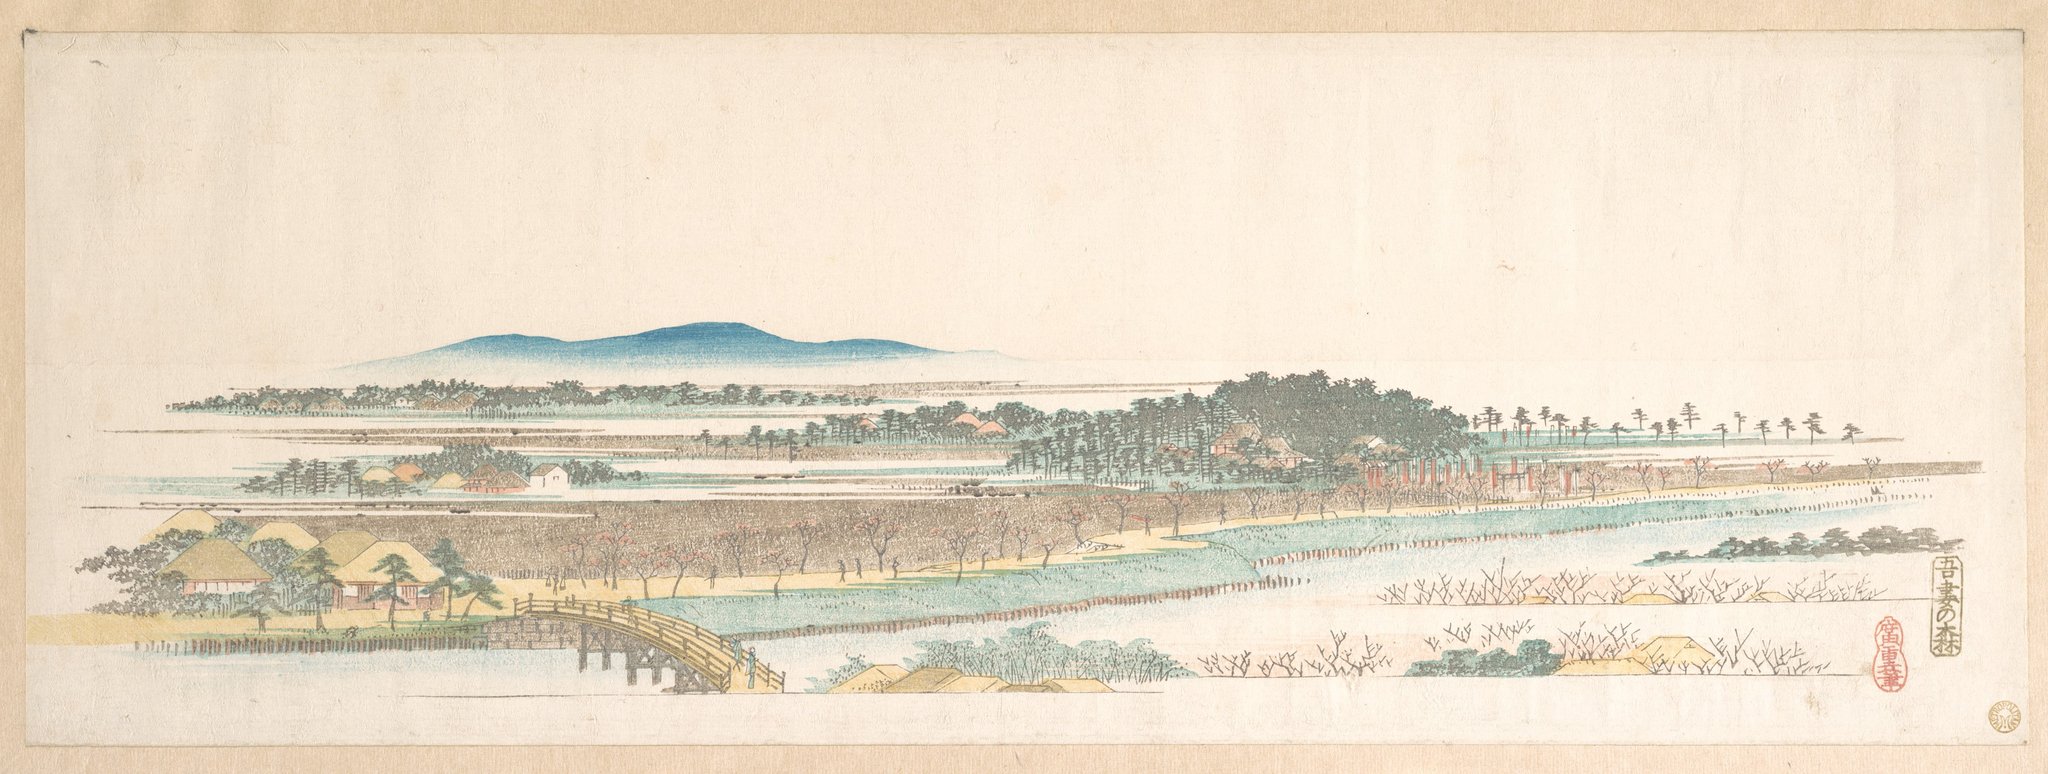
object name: print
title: View of Azuma Wood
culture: japanese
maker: utagawa hiroshige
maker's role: artist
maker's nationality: japanese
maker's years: 1797-1858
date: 1858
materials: ink, paper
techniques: surimono, woodblock print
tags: landscapes,trees